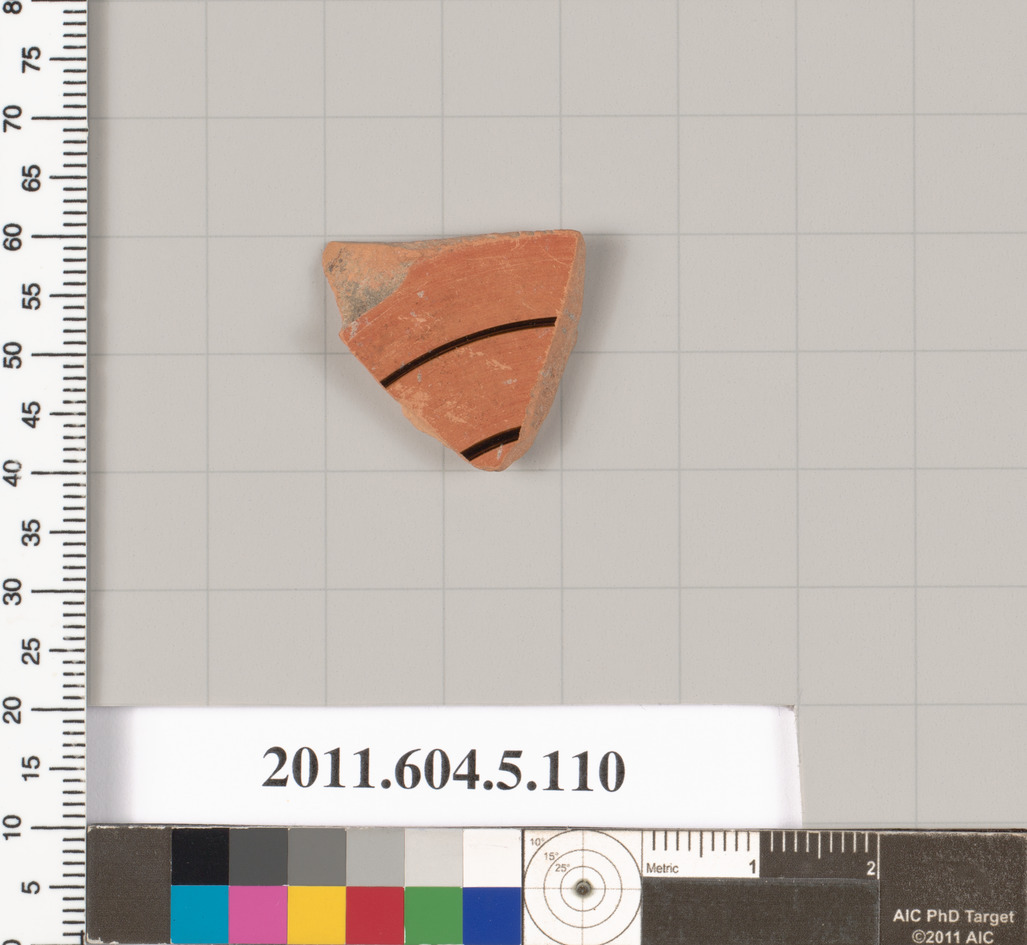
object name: kylix fragment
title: Terracotta fragment of a stemless kylix (drinking cup)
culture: greek, attic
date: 470-450 BCE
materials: terracotta